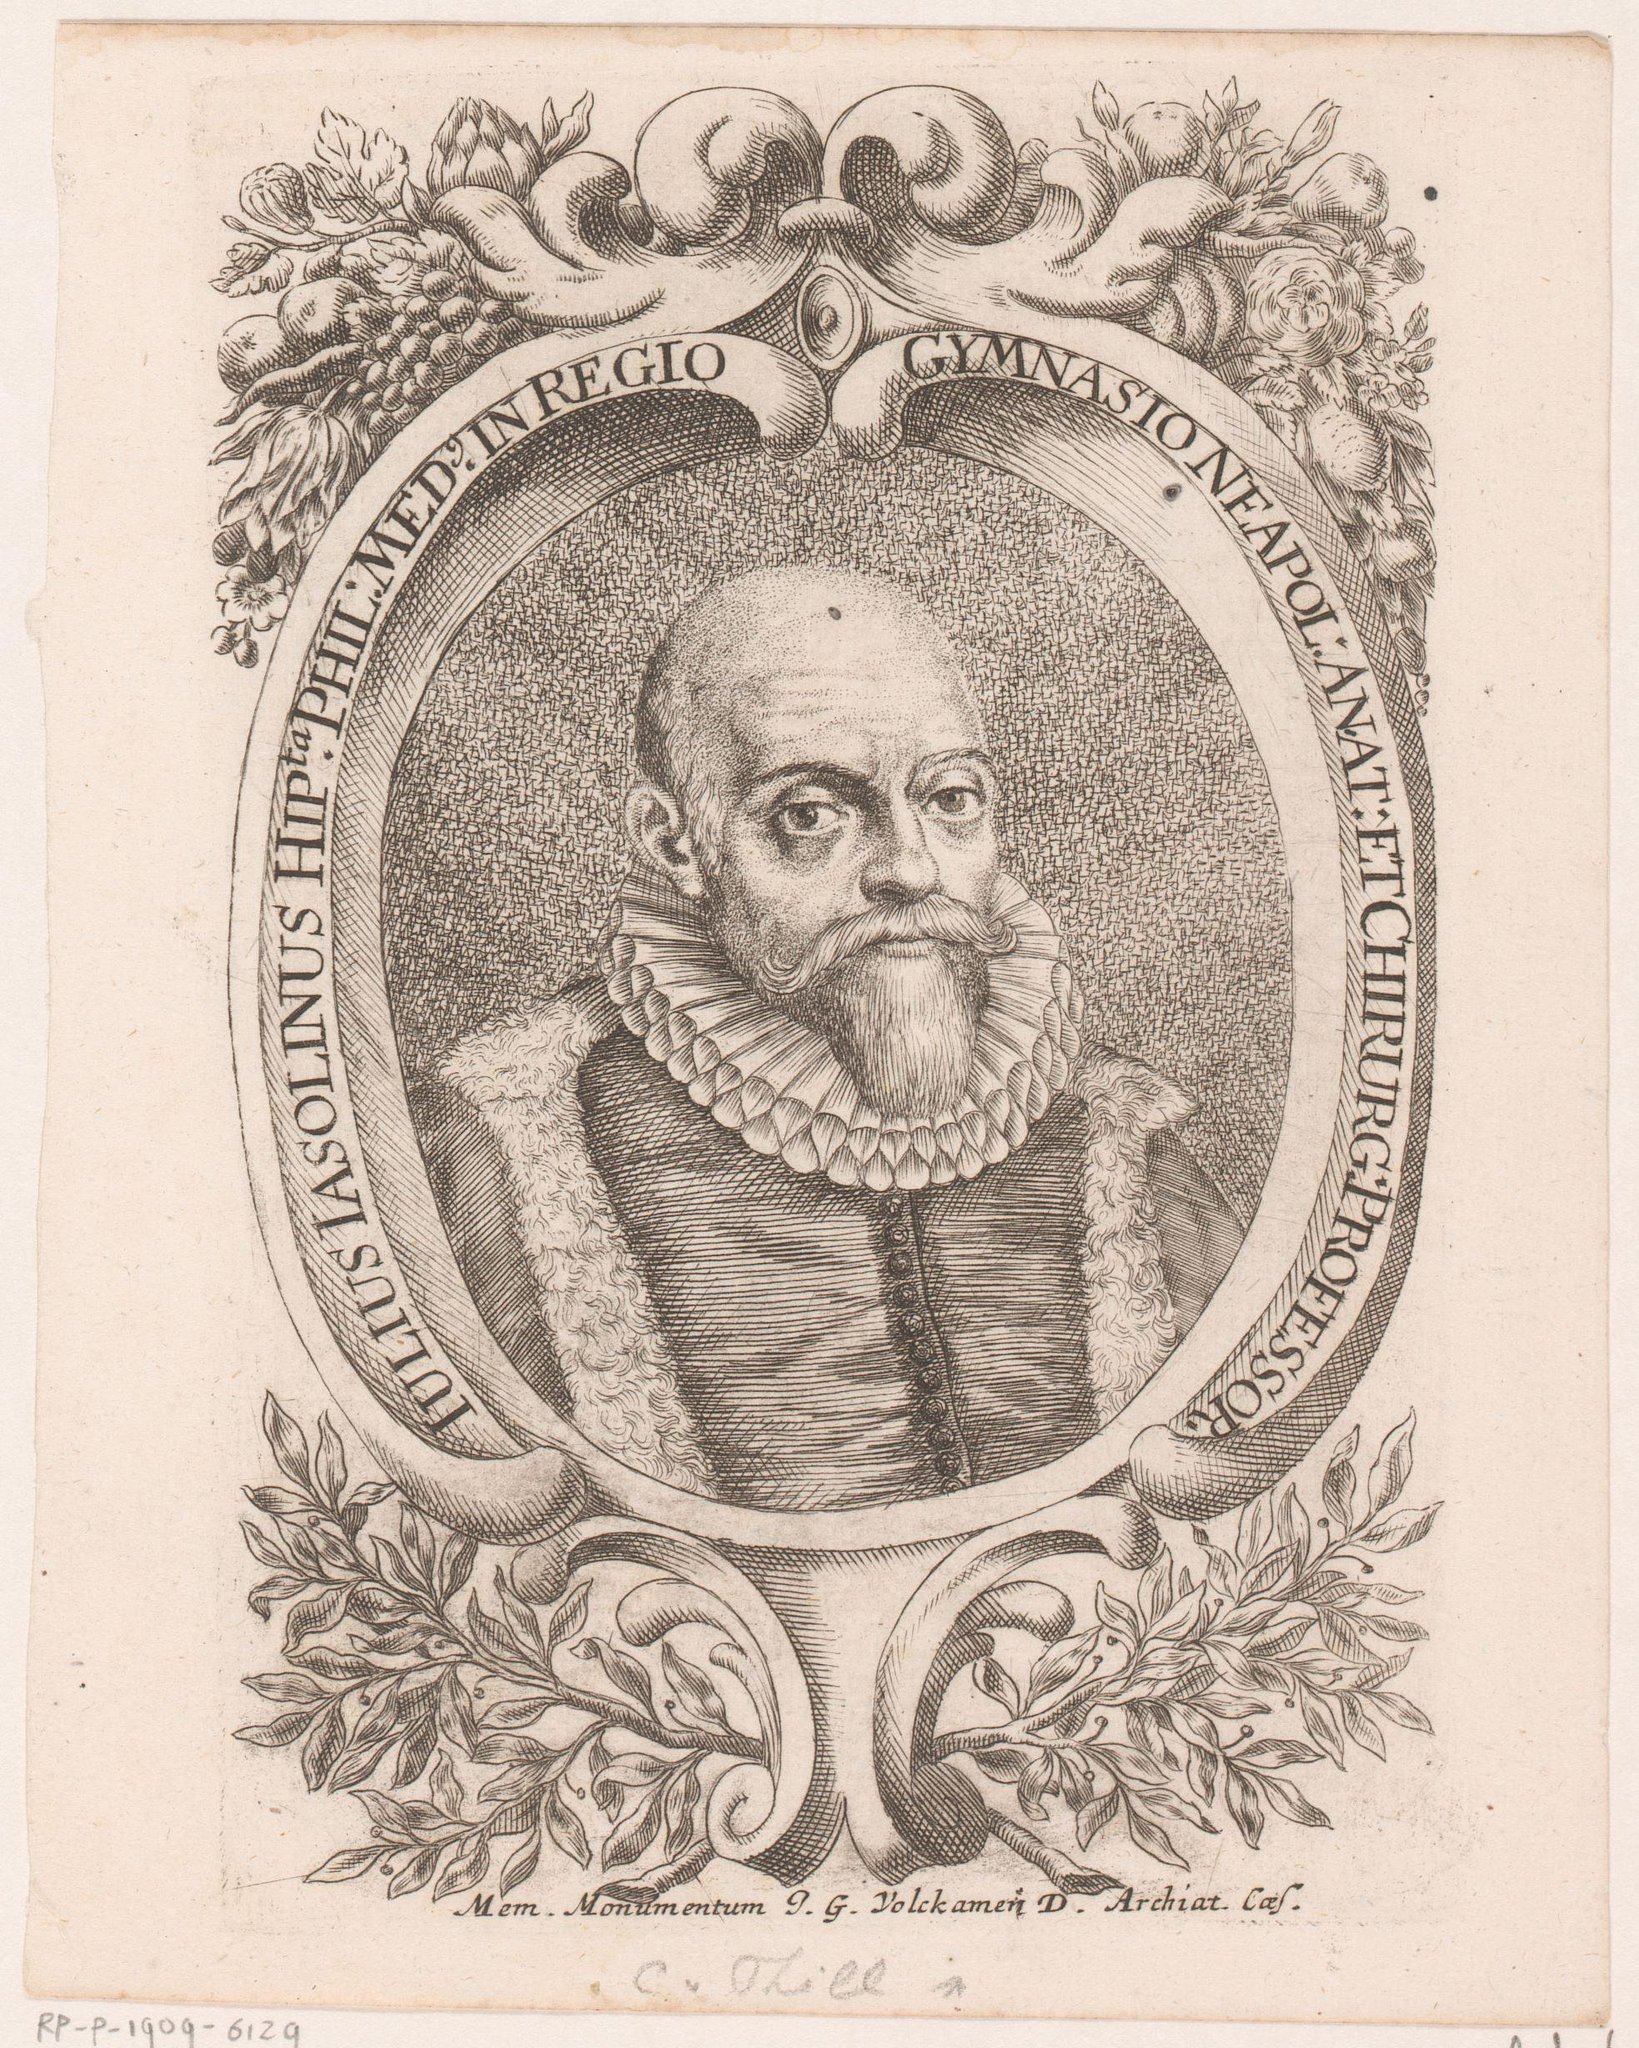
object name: print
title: Portret van Giulio Jasolino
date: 1630-1676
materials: paper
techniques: etching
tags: vibo valentia (province), naples, giulio jasolino, historical persons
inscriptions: collector's mark: Lugt 2228